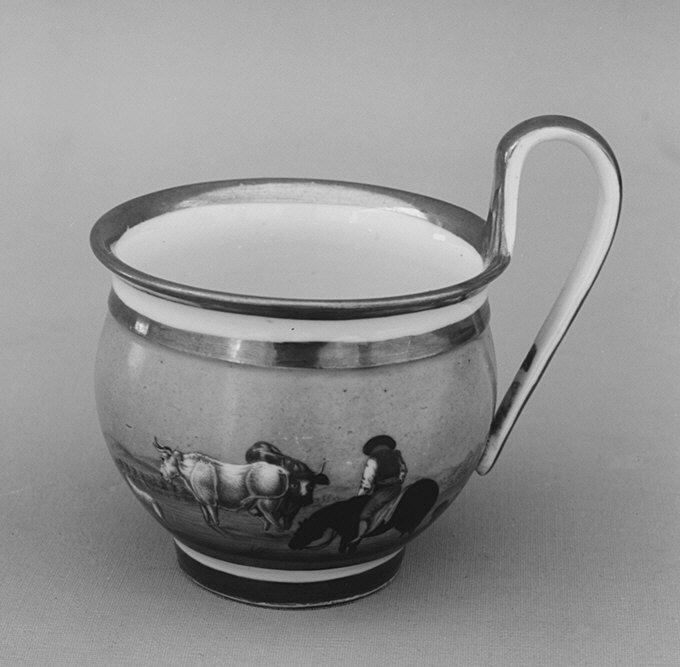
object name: cup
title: Cup (one of six) (part of a set)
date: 1820-1830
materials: hard paste porcelain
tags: cows,horses